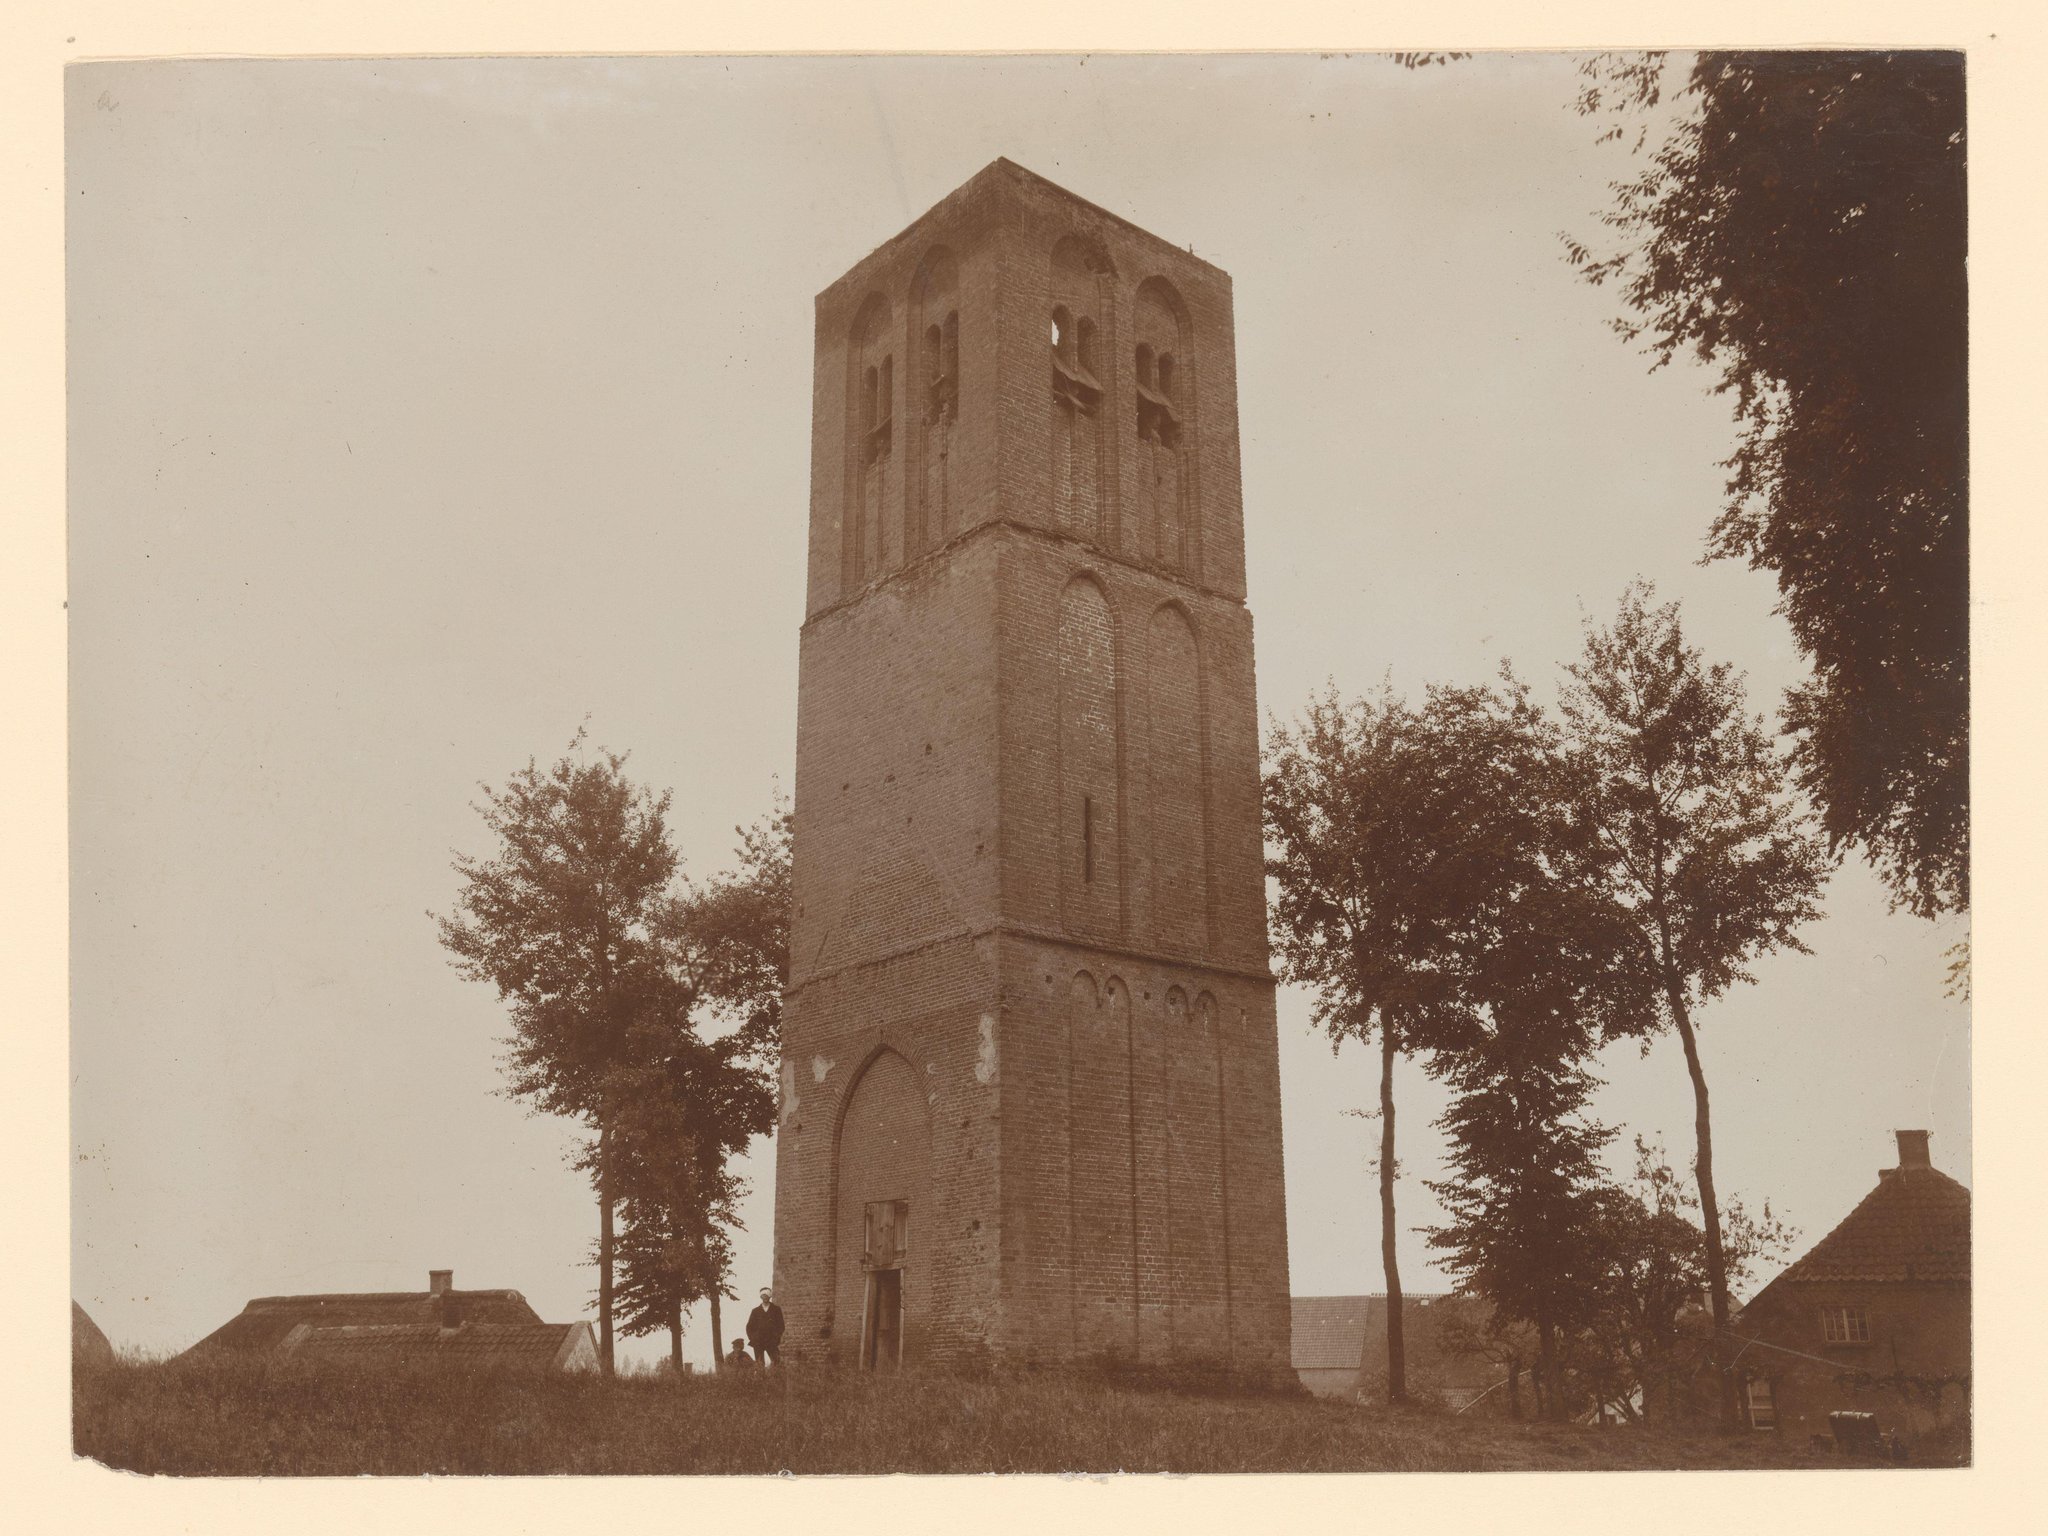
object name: photograph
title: Gezicht op een oude kerktoren te Puiflijk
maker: anoniem (monumentenzorg)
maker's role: fotograaf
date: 1890-1920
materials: cardboard, photographic support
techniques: collodion silver print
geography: puiflijk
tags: parts of church exterior and annexes: tower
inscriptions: annotation: ‘a/ gem. Druten’, annotation: ‘Toren te Puiflijk (Puijfelijk G.)’